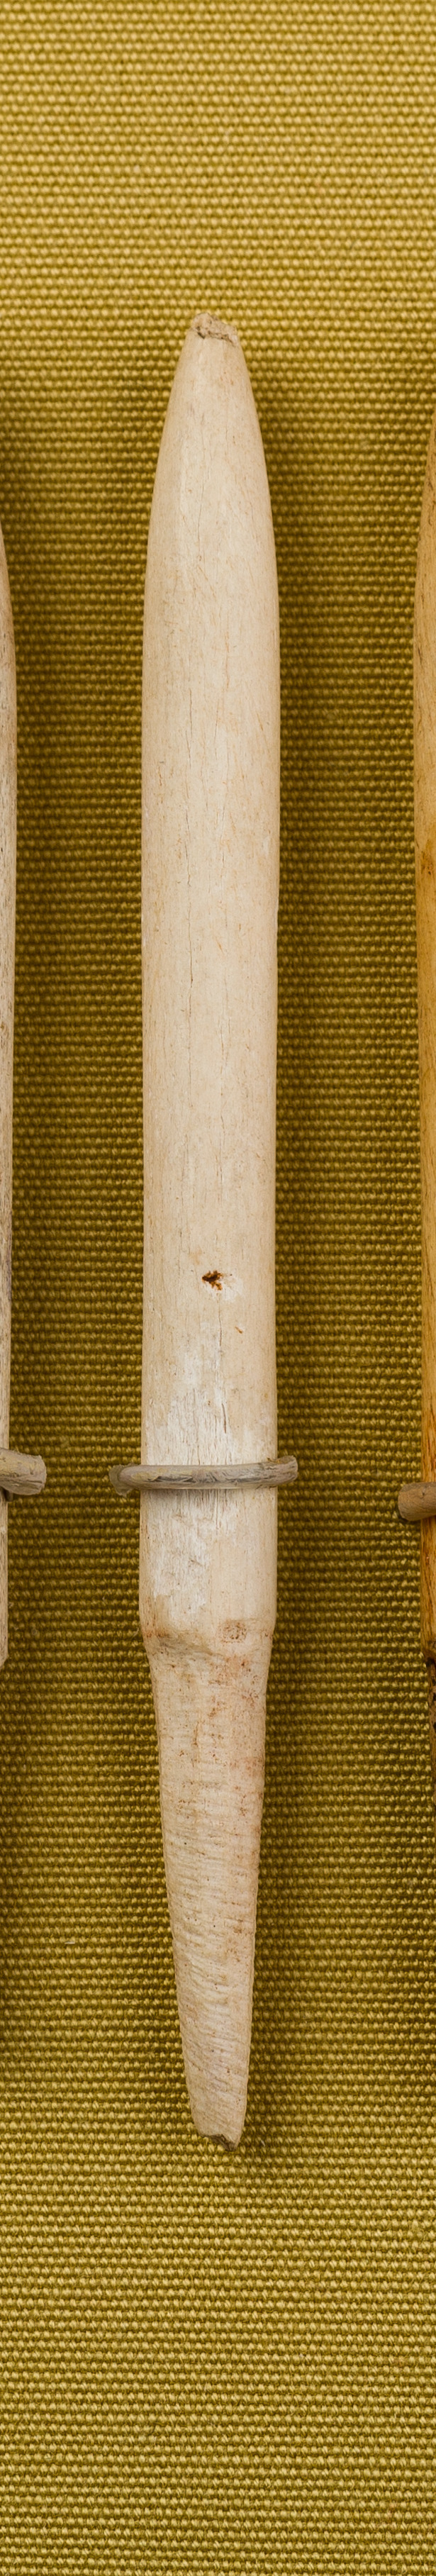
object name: arrowhead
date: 3100-2900 BCE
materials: ivory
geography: egypt